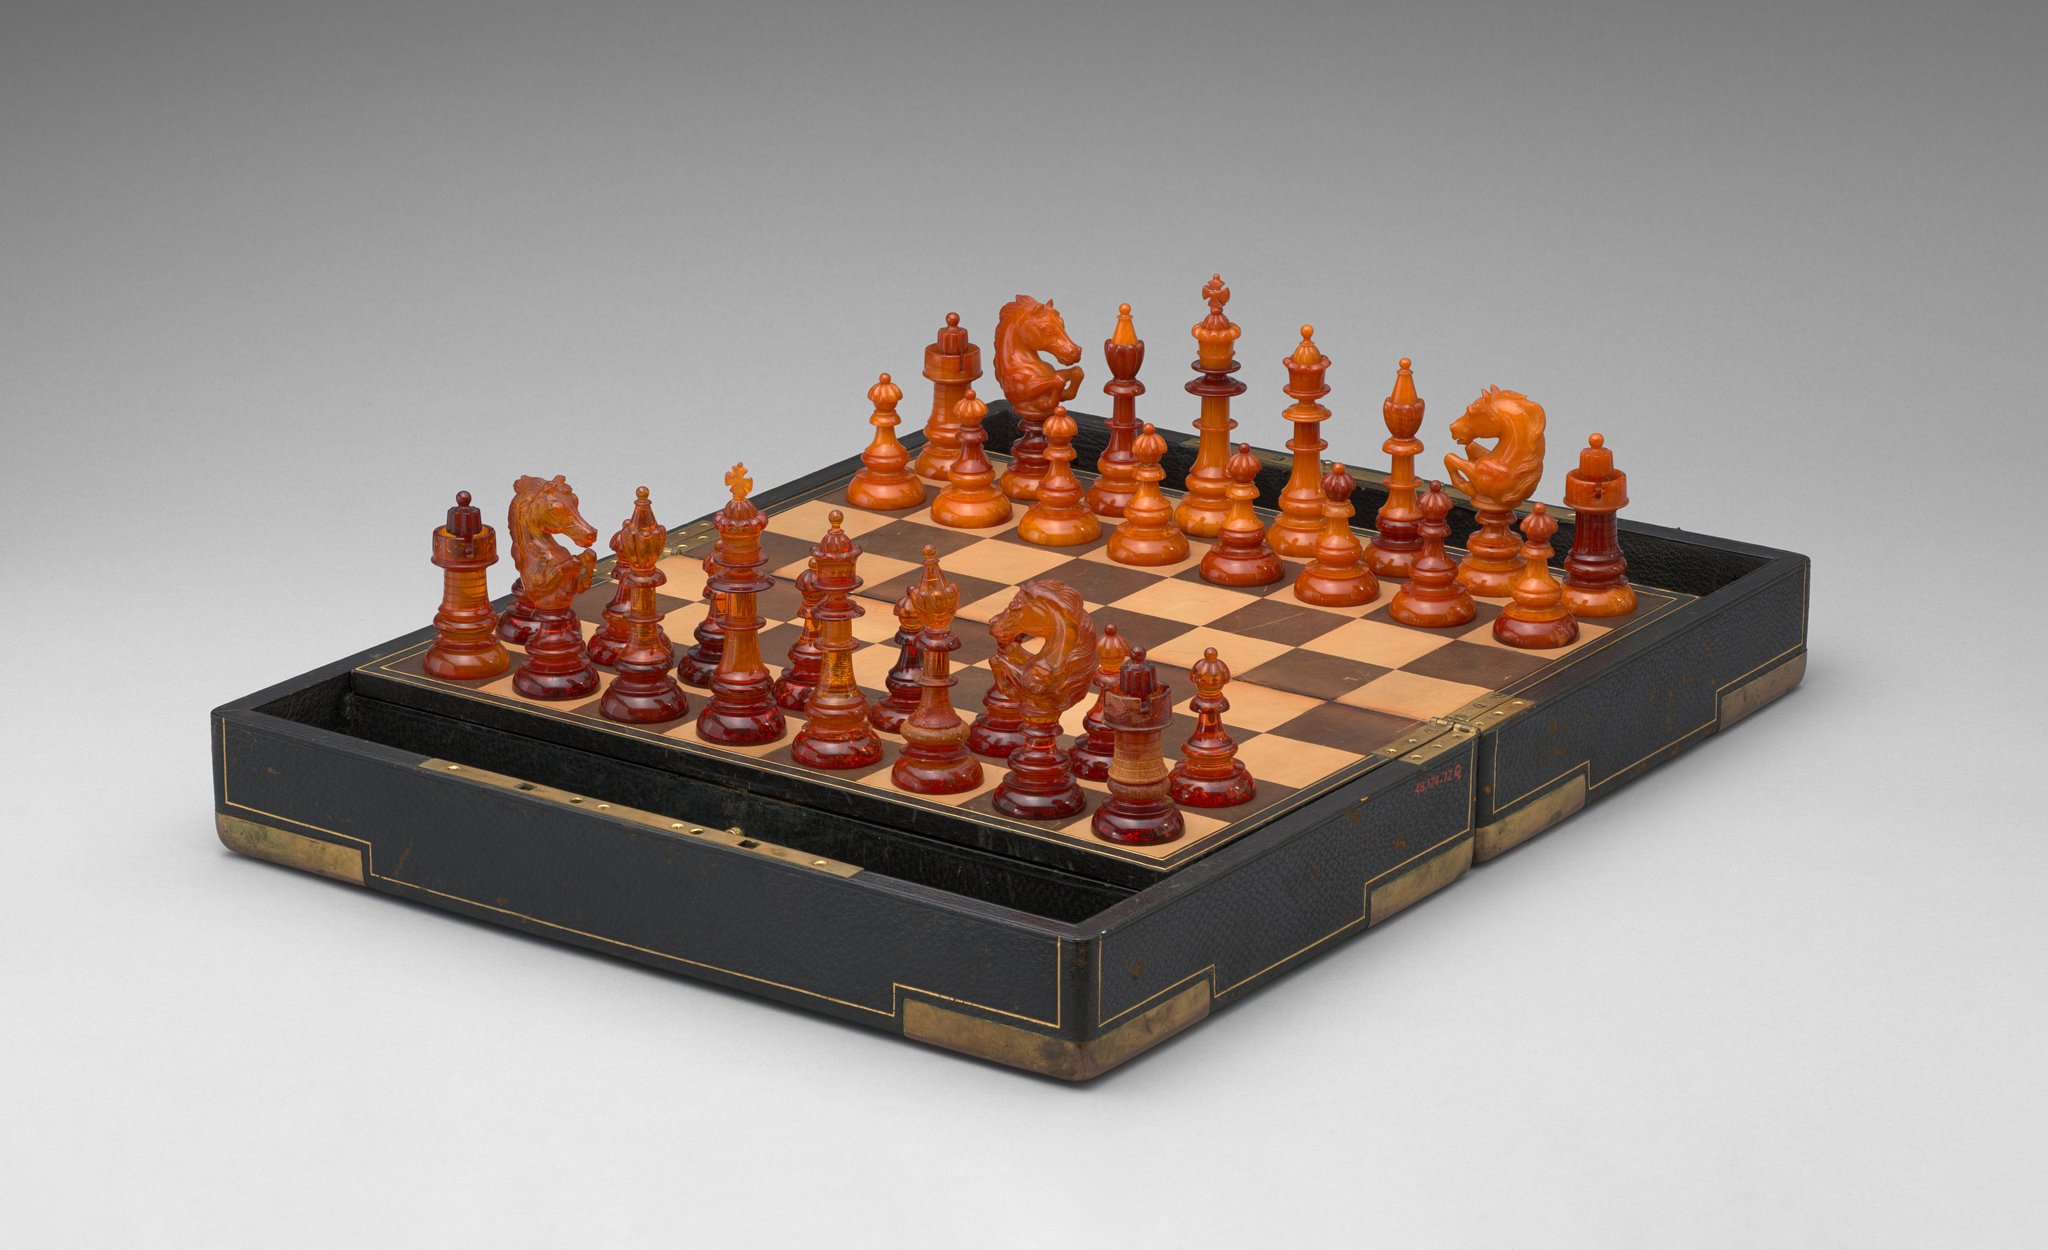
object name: chessman and box board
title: Chessmen (32) and box-board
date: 1801-1900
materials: amber, brass, leather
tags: chess